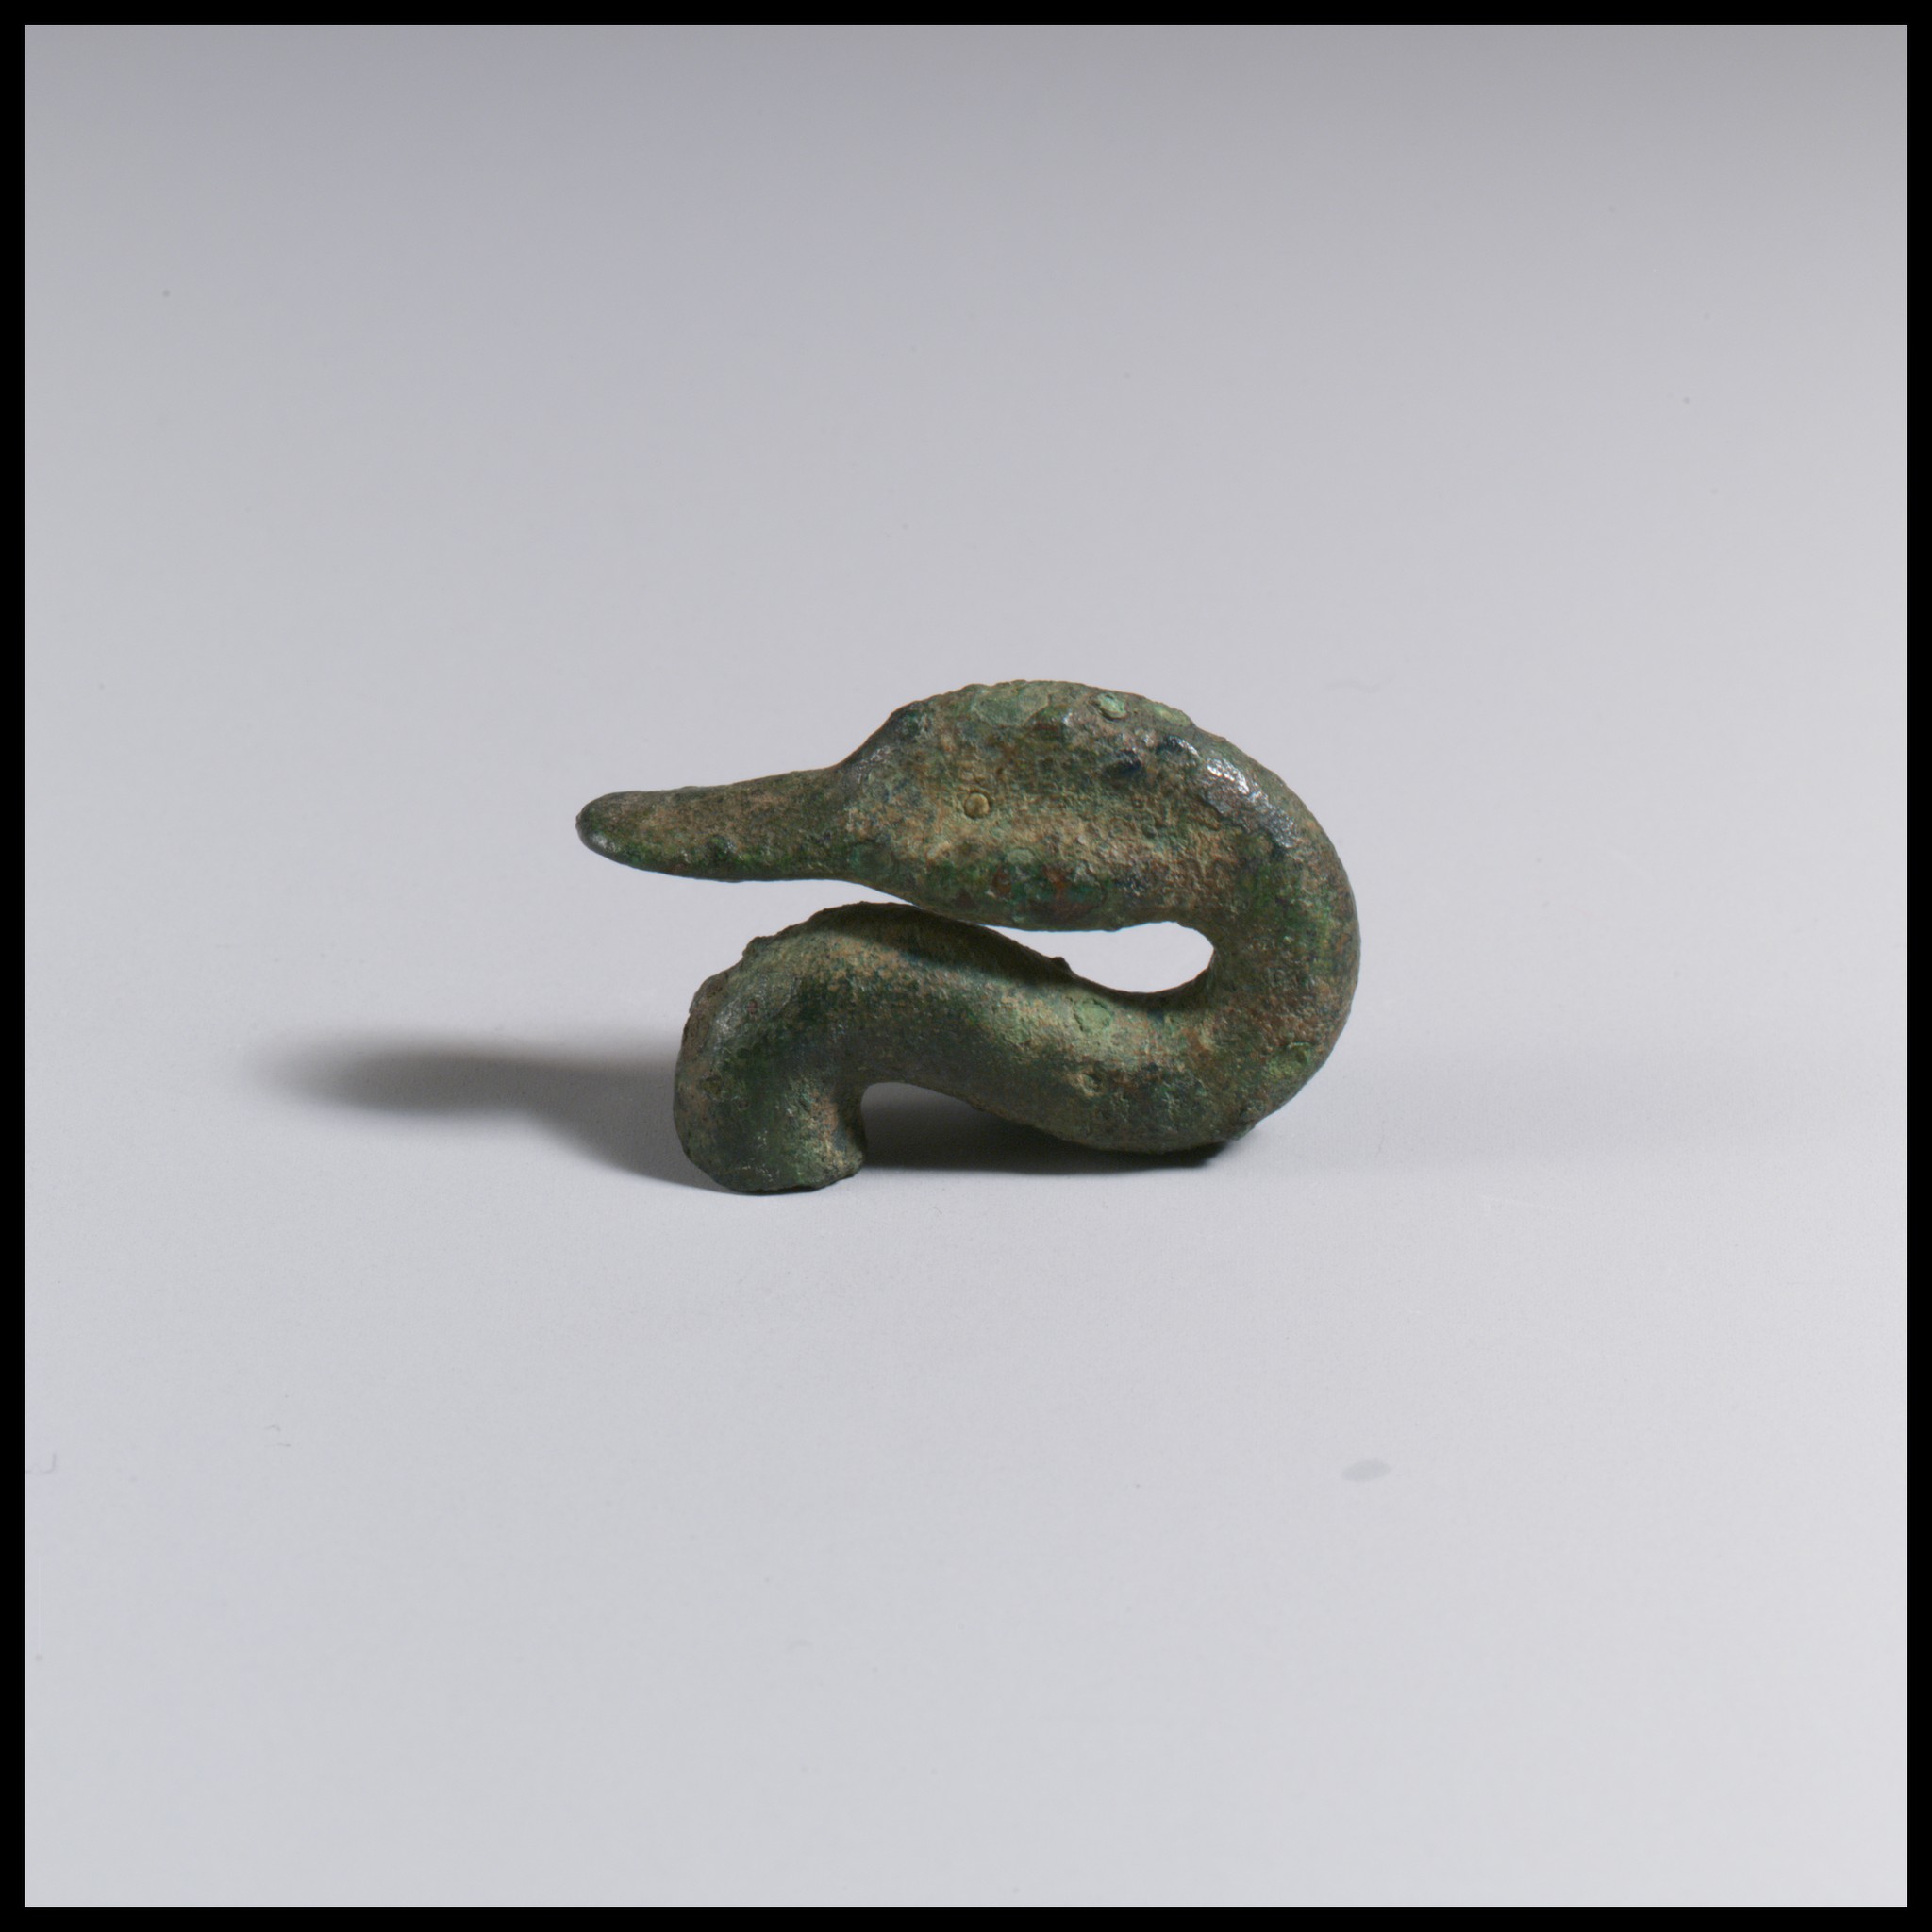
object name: statuette of a swan, fragment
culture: roman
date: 670 BCE-330 CE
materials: bronze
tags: swans